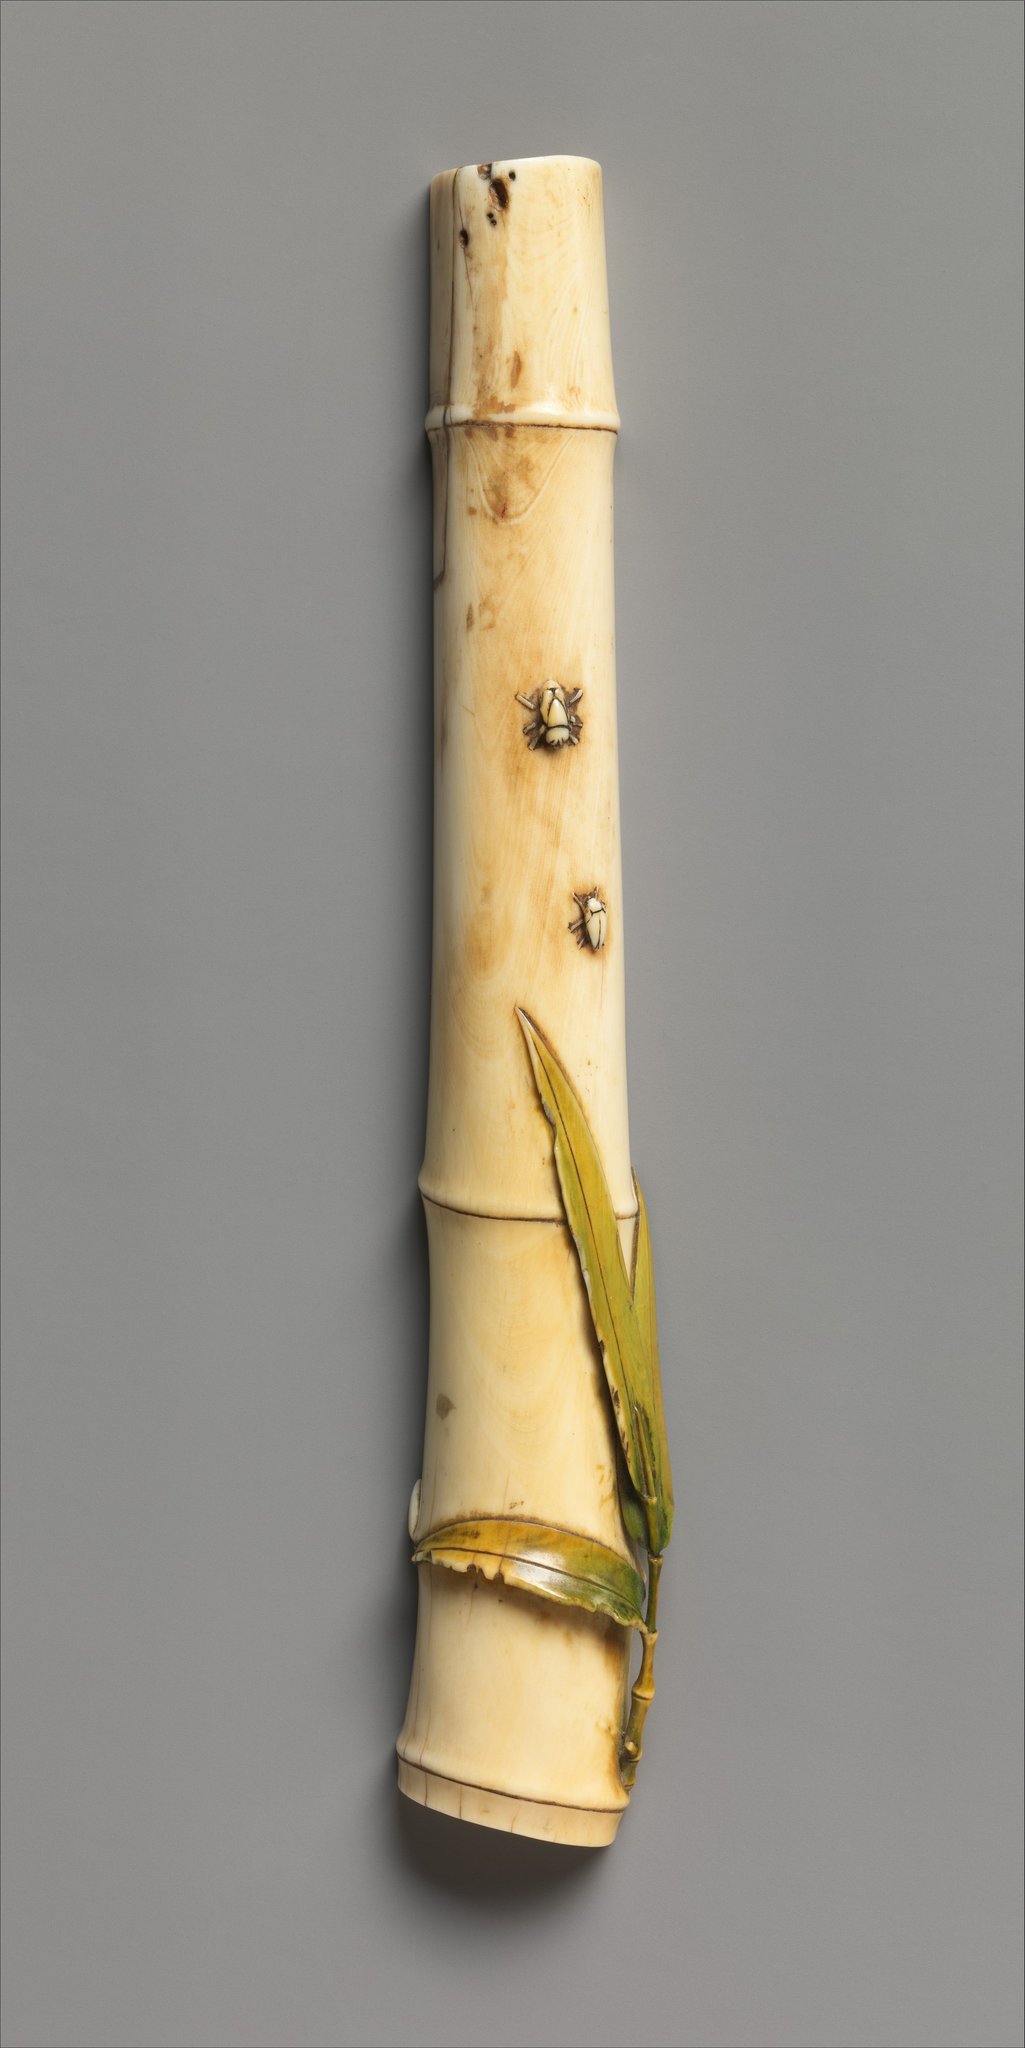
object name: carving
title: Bamboo stalk with insects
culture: chinese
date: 1701-1800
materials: ivory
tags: insects,bamboo